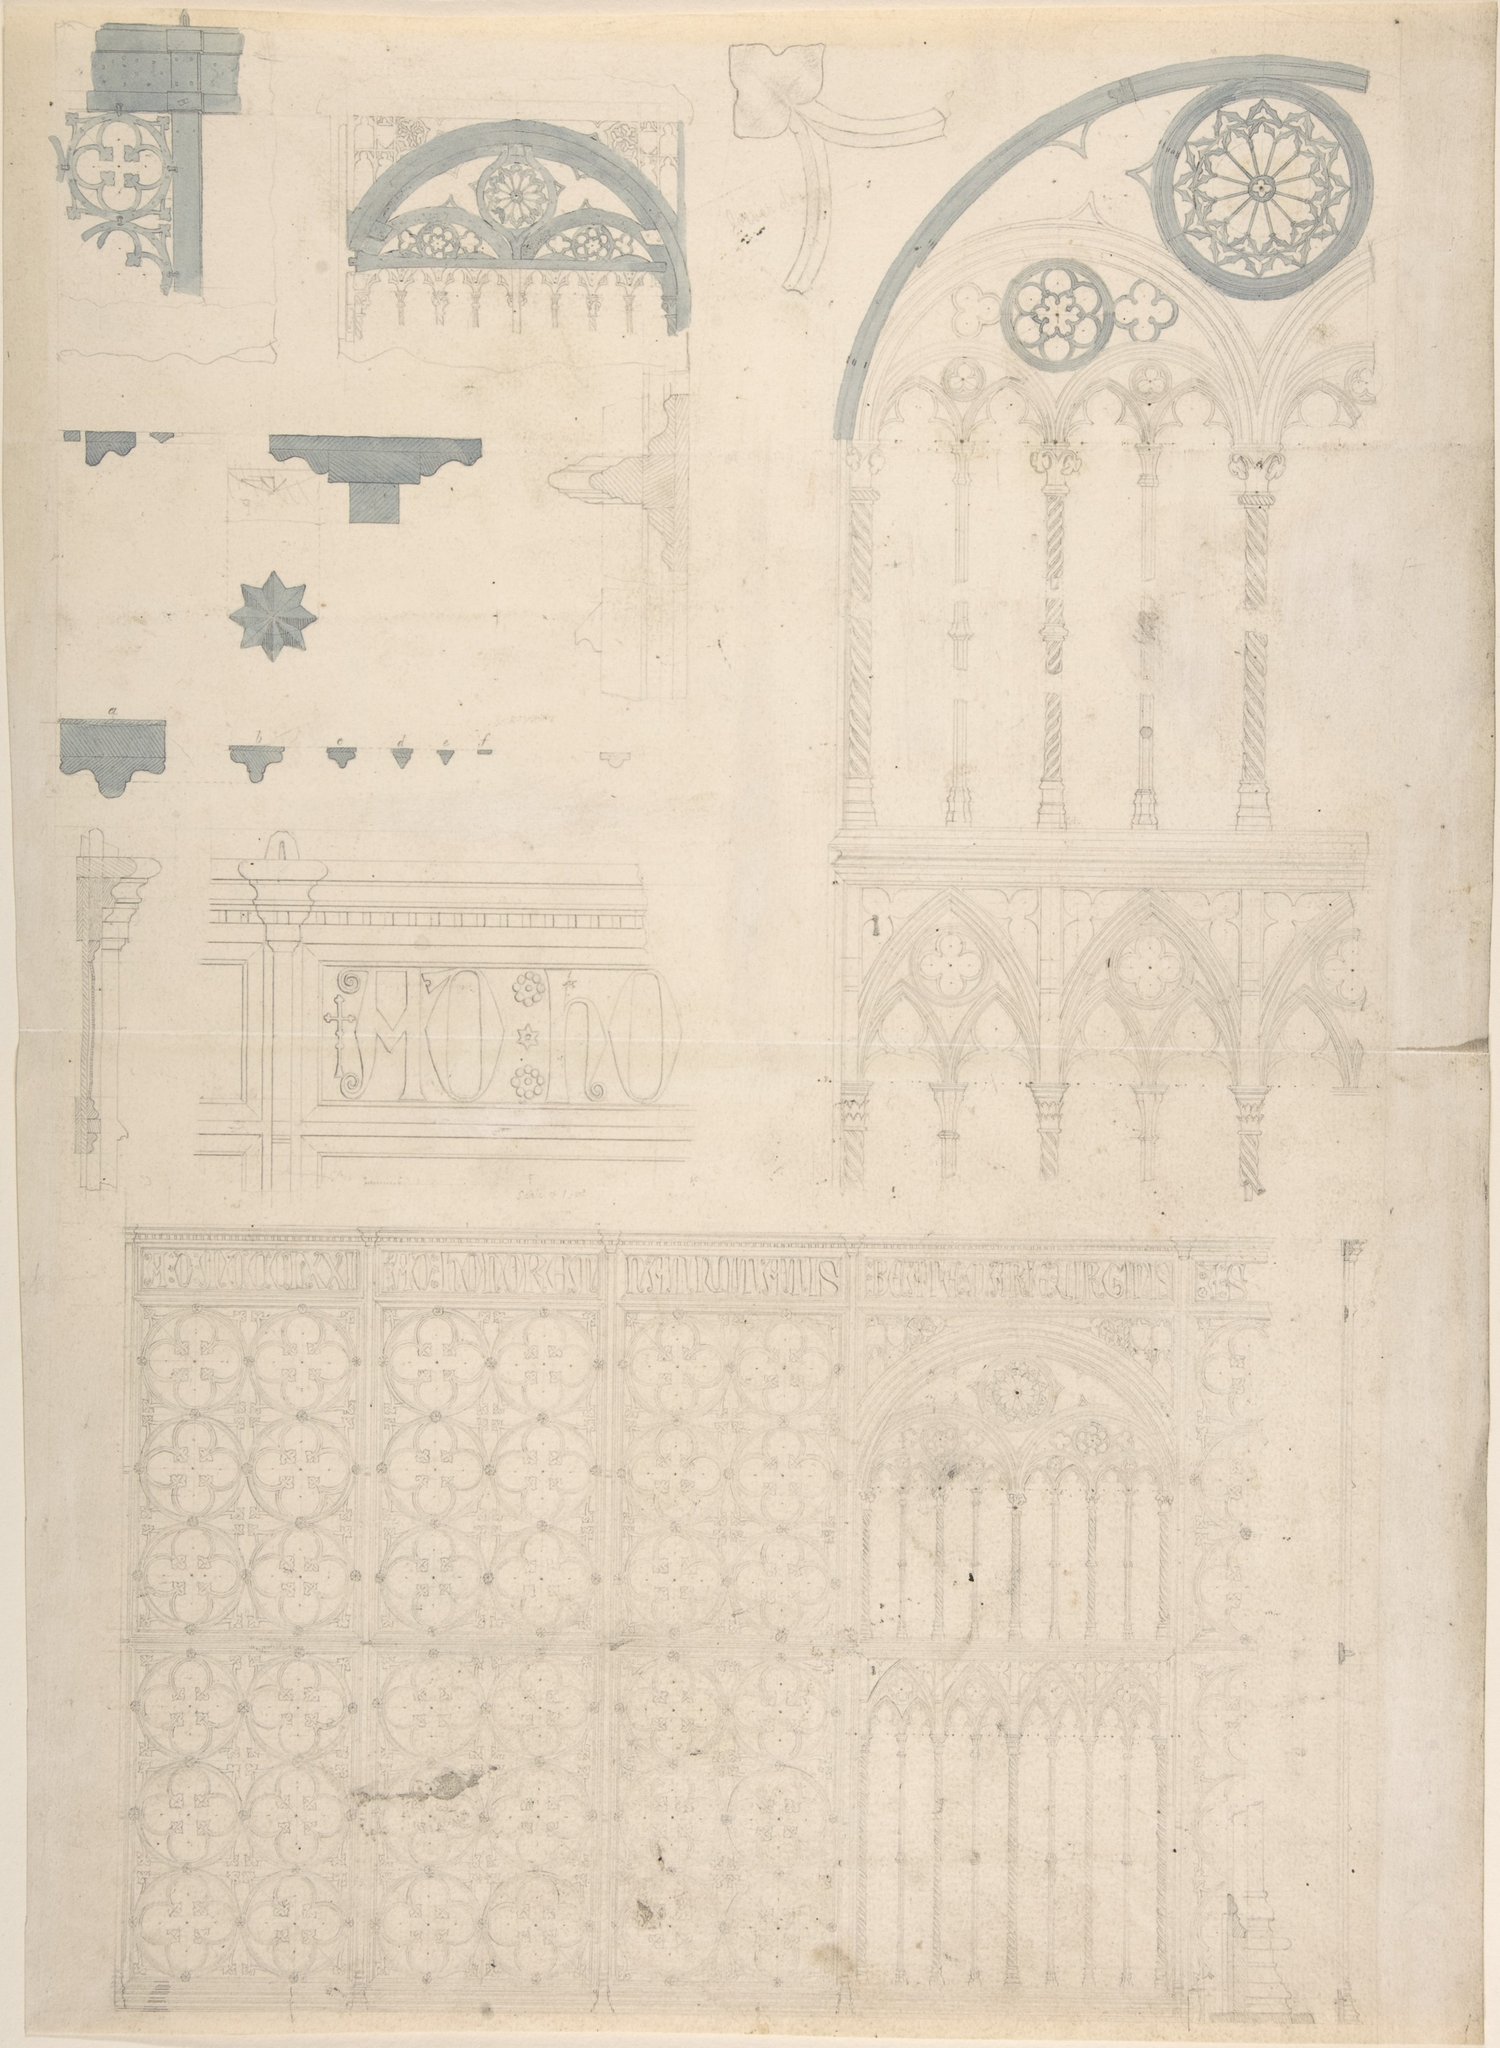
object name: drawing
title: Tracery and Church Ornament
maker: anonymous, british, 19th century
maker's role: artist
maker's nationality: british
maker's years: 1800-1900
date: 1851-1900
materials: graphite, watercolor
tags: ornament